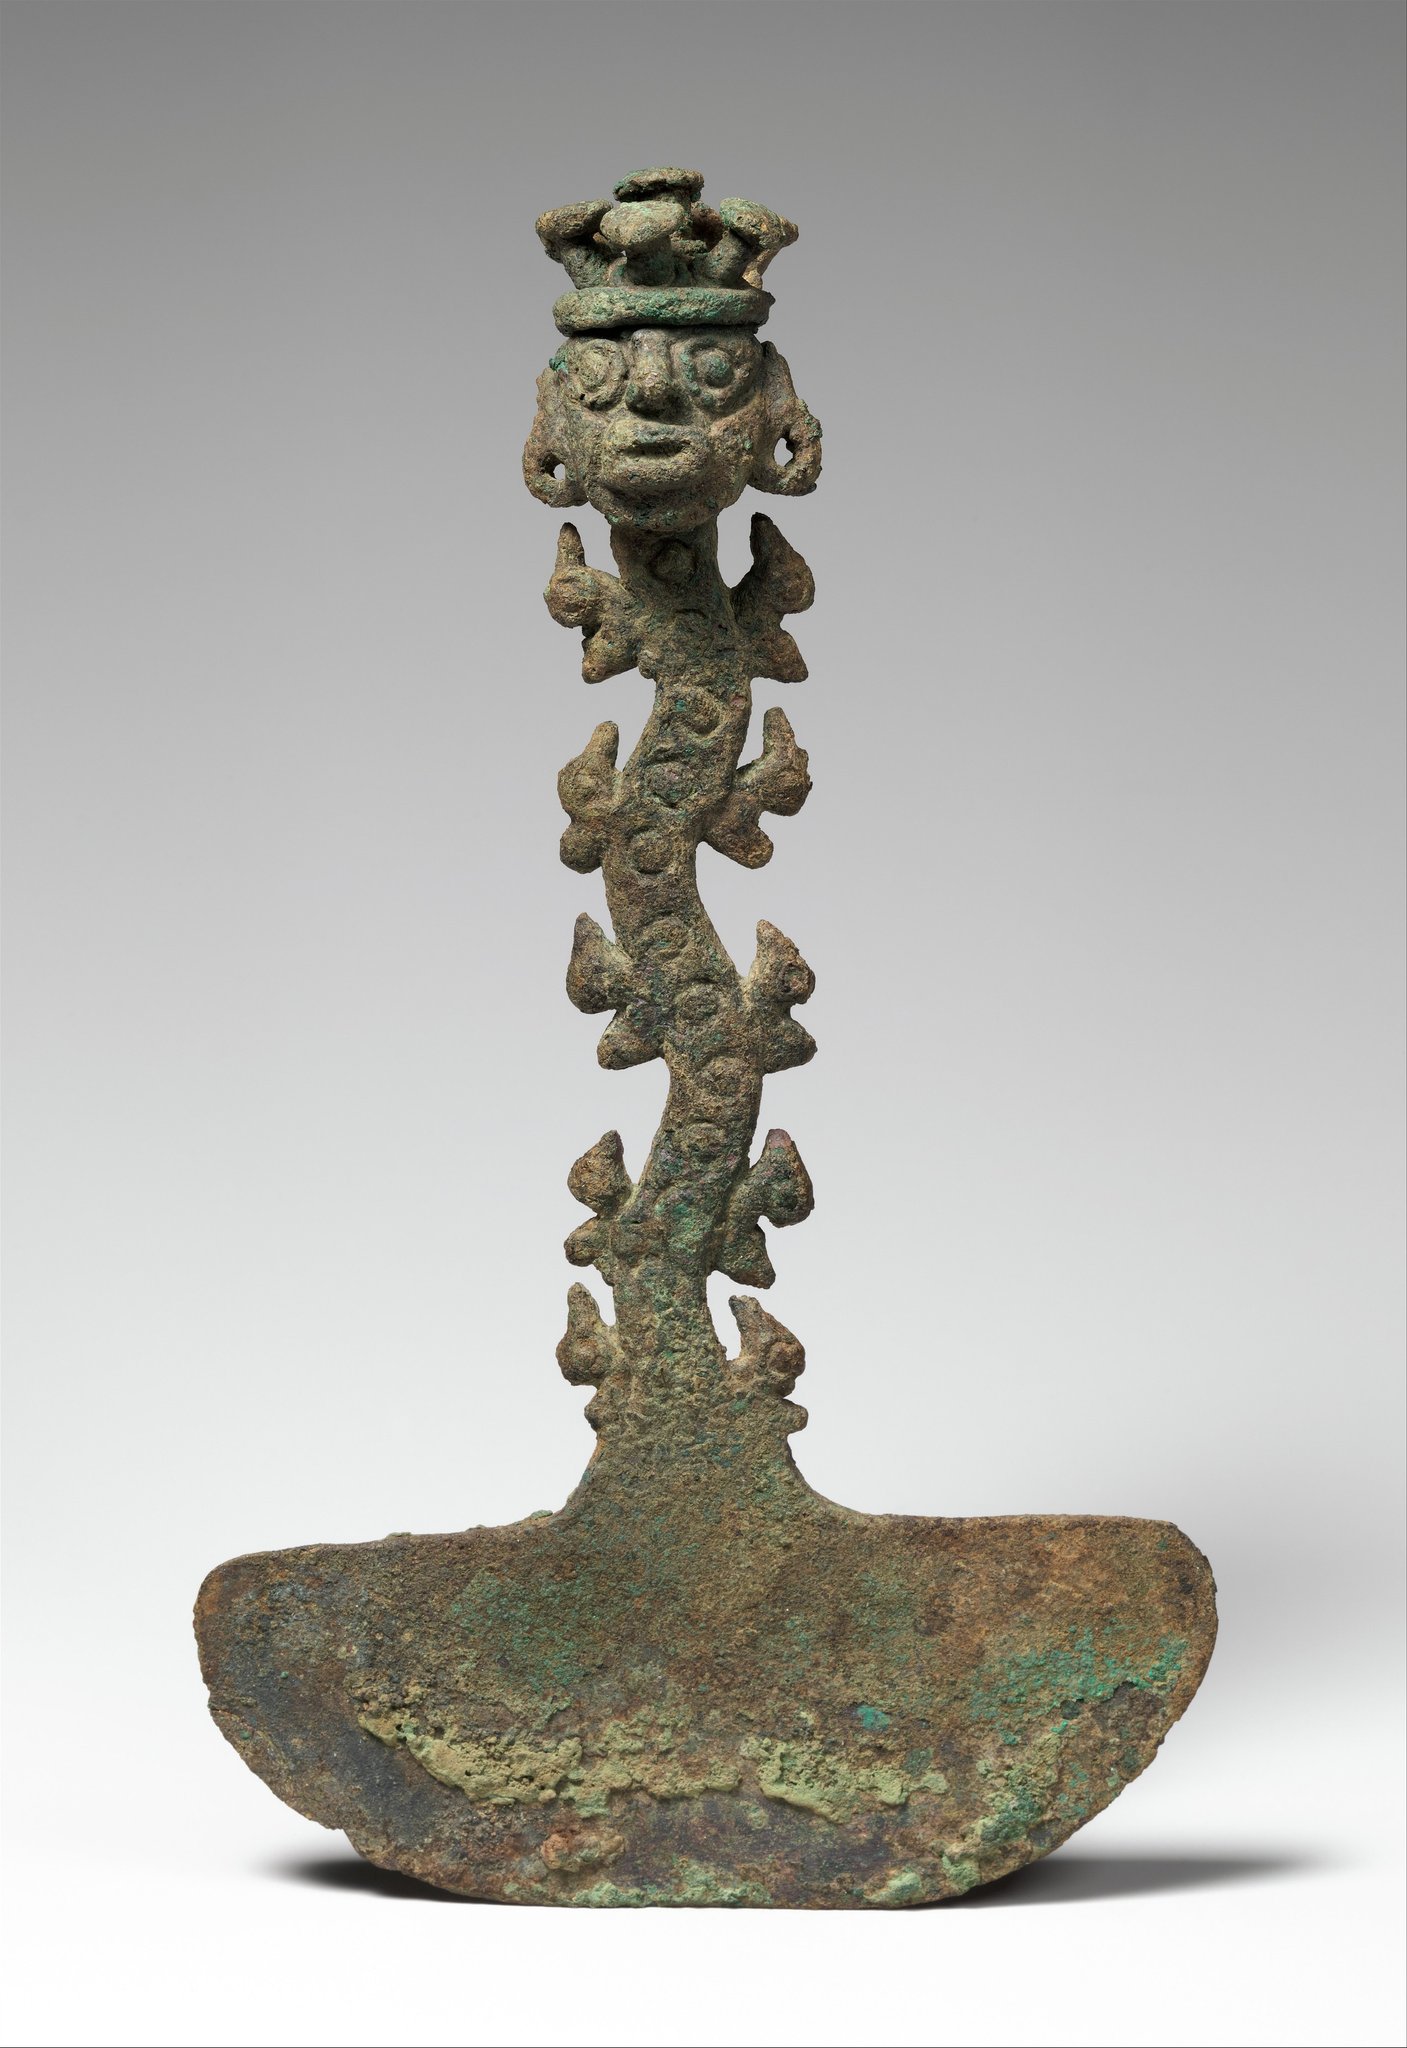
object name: knife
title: Ceremonial Knife (Tumi)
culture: chimú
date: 1101-1500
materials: copper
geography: peru